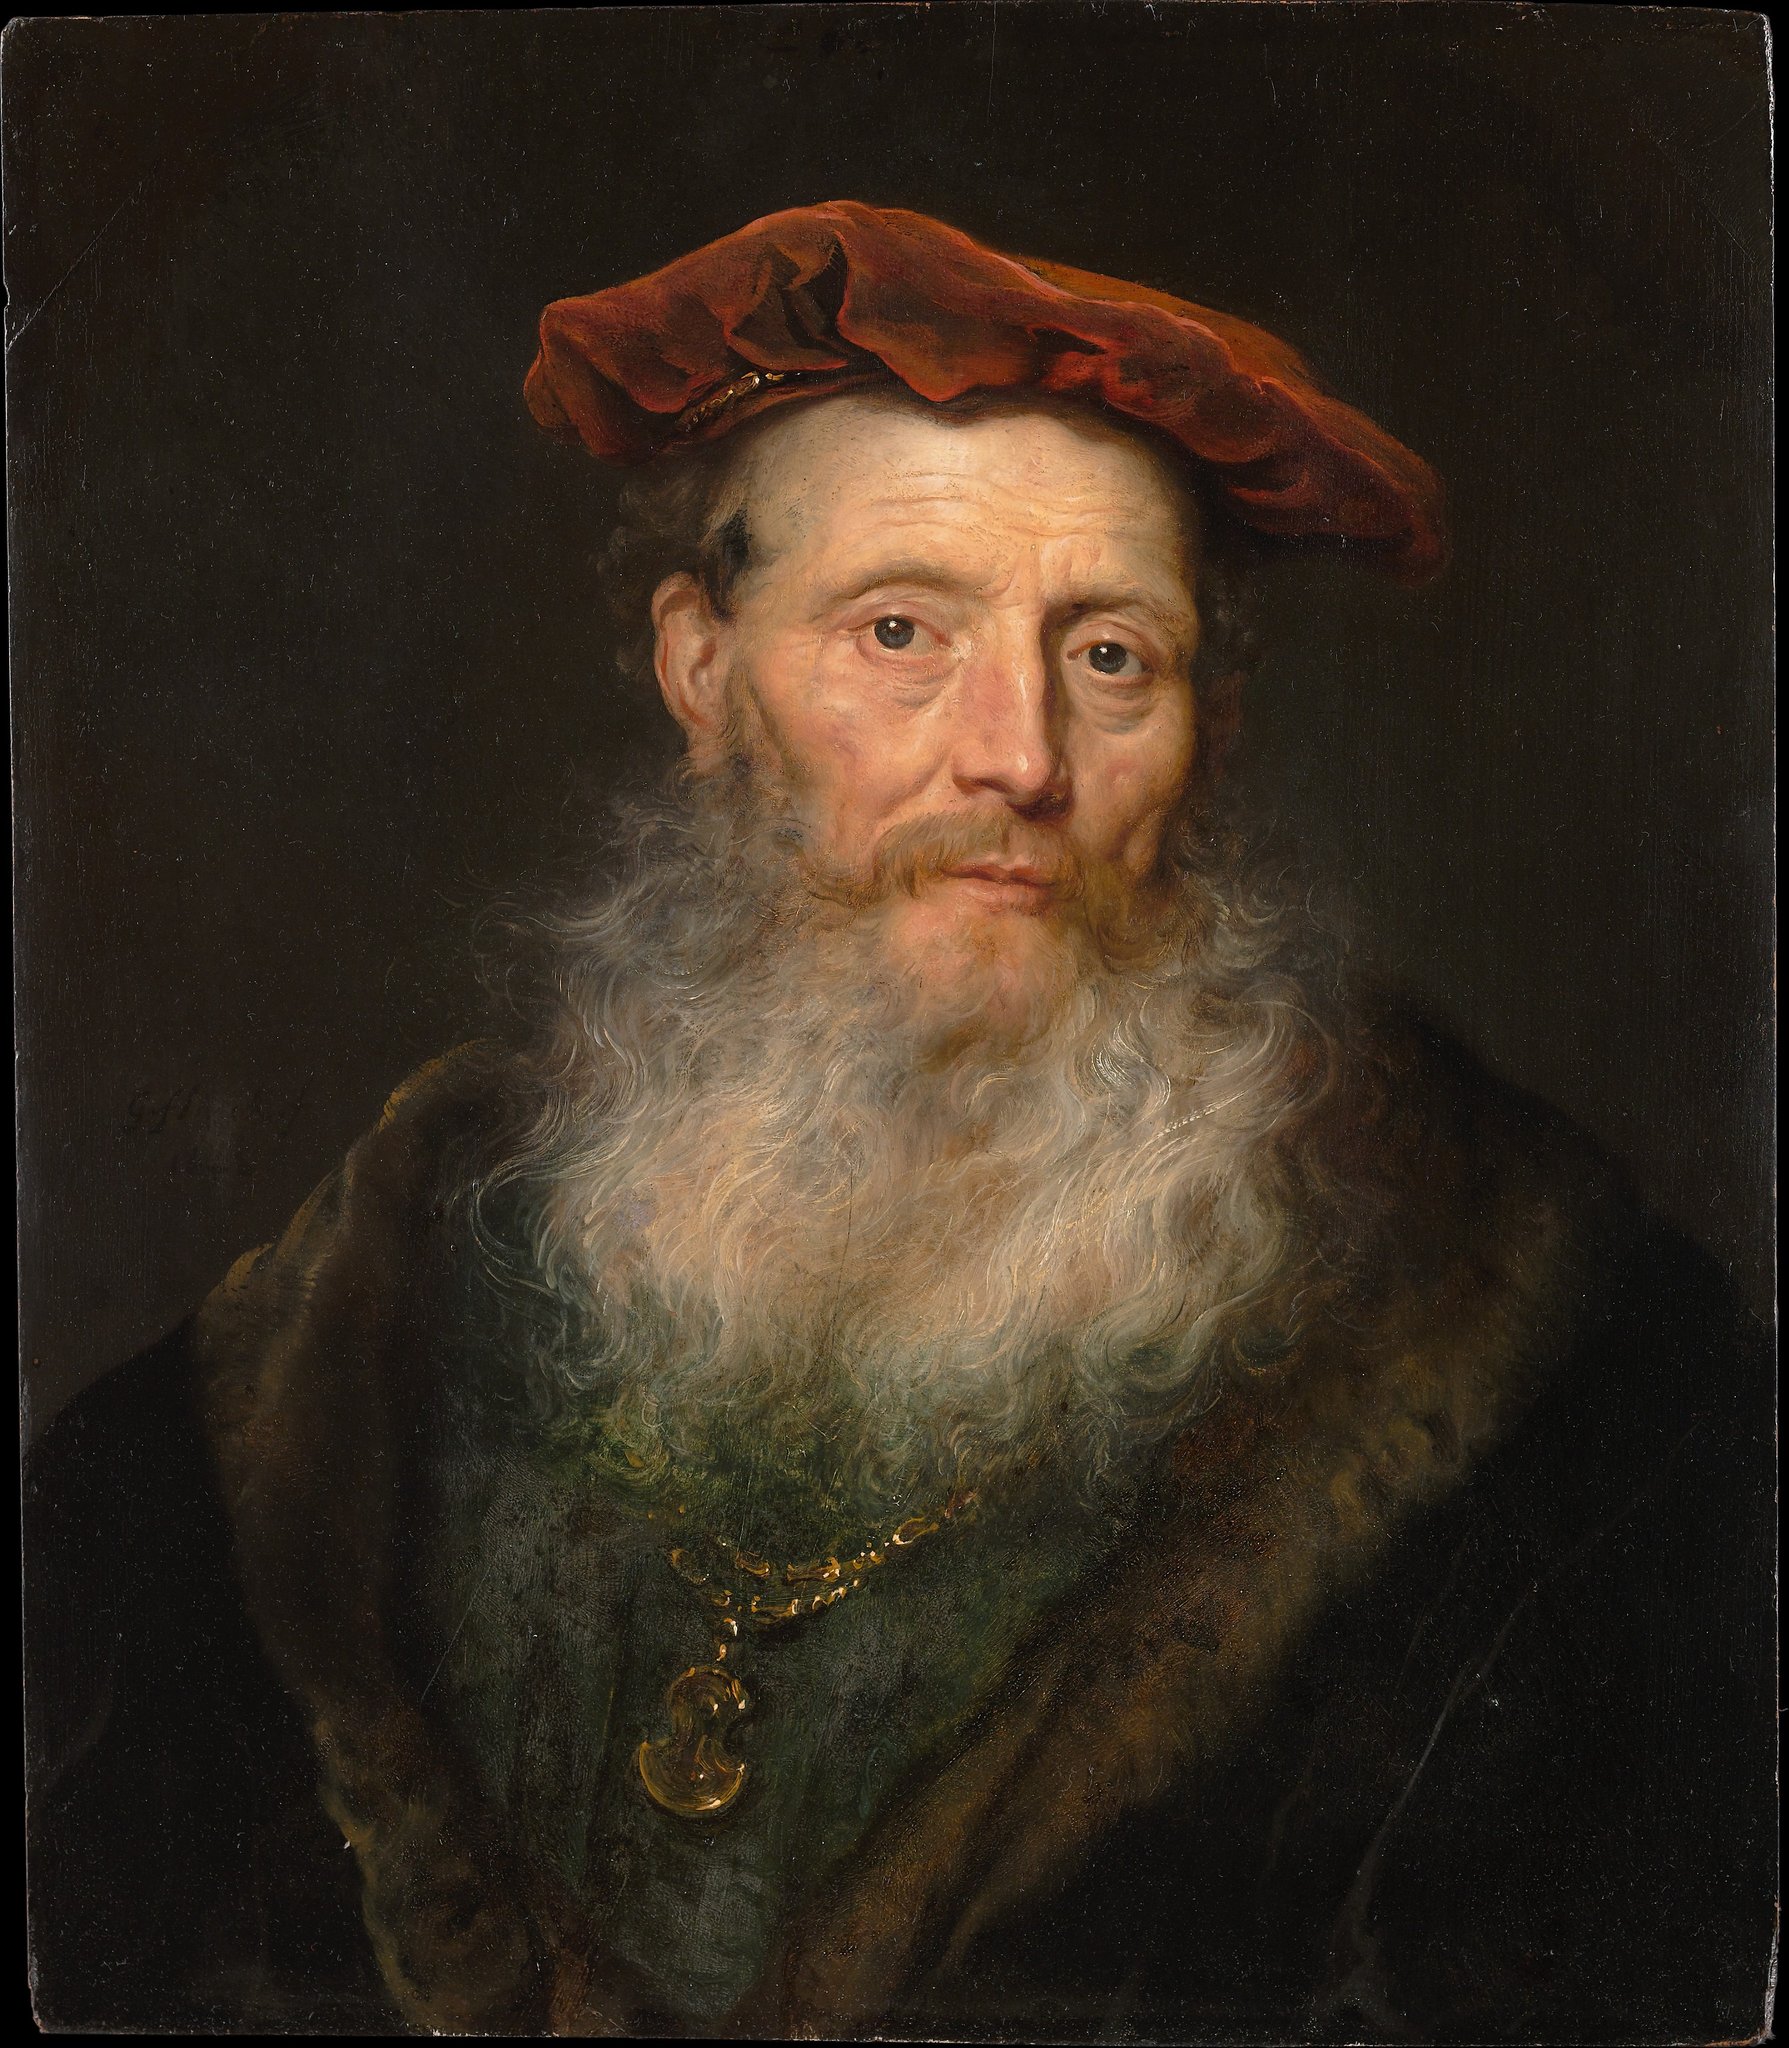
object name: painting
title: Bearded Man with a Velvet Cap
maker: govert flinck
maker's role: artist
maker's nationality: dutch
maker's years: 1615-1660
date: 1645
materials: oil, wood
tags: men,portraits